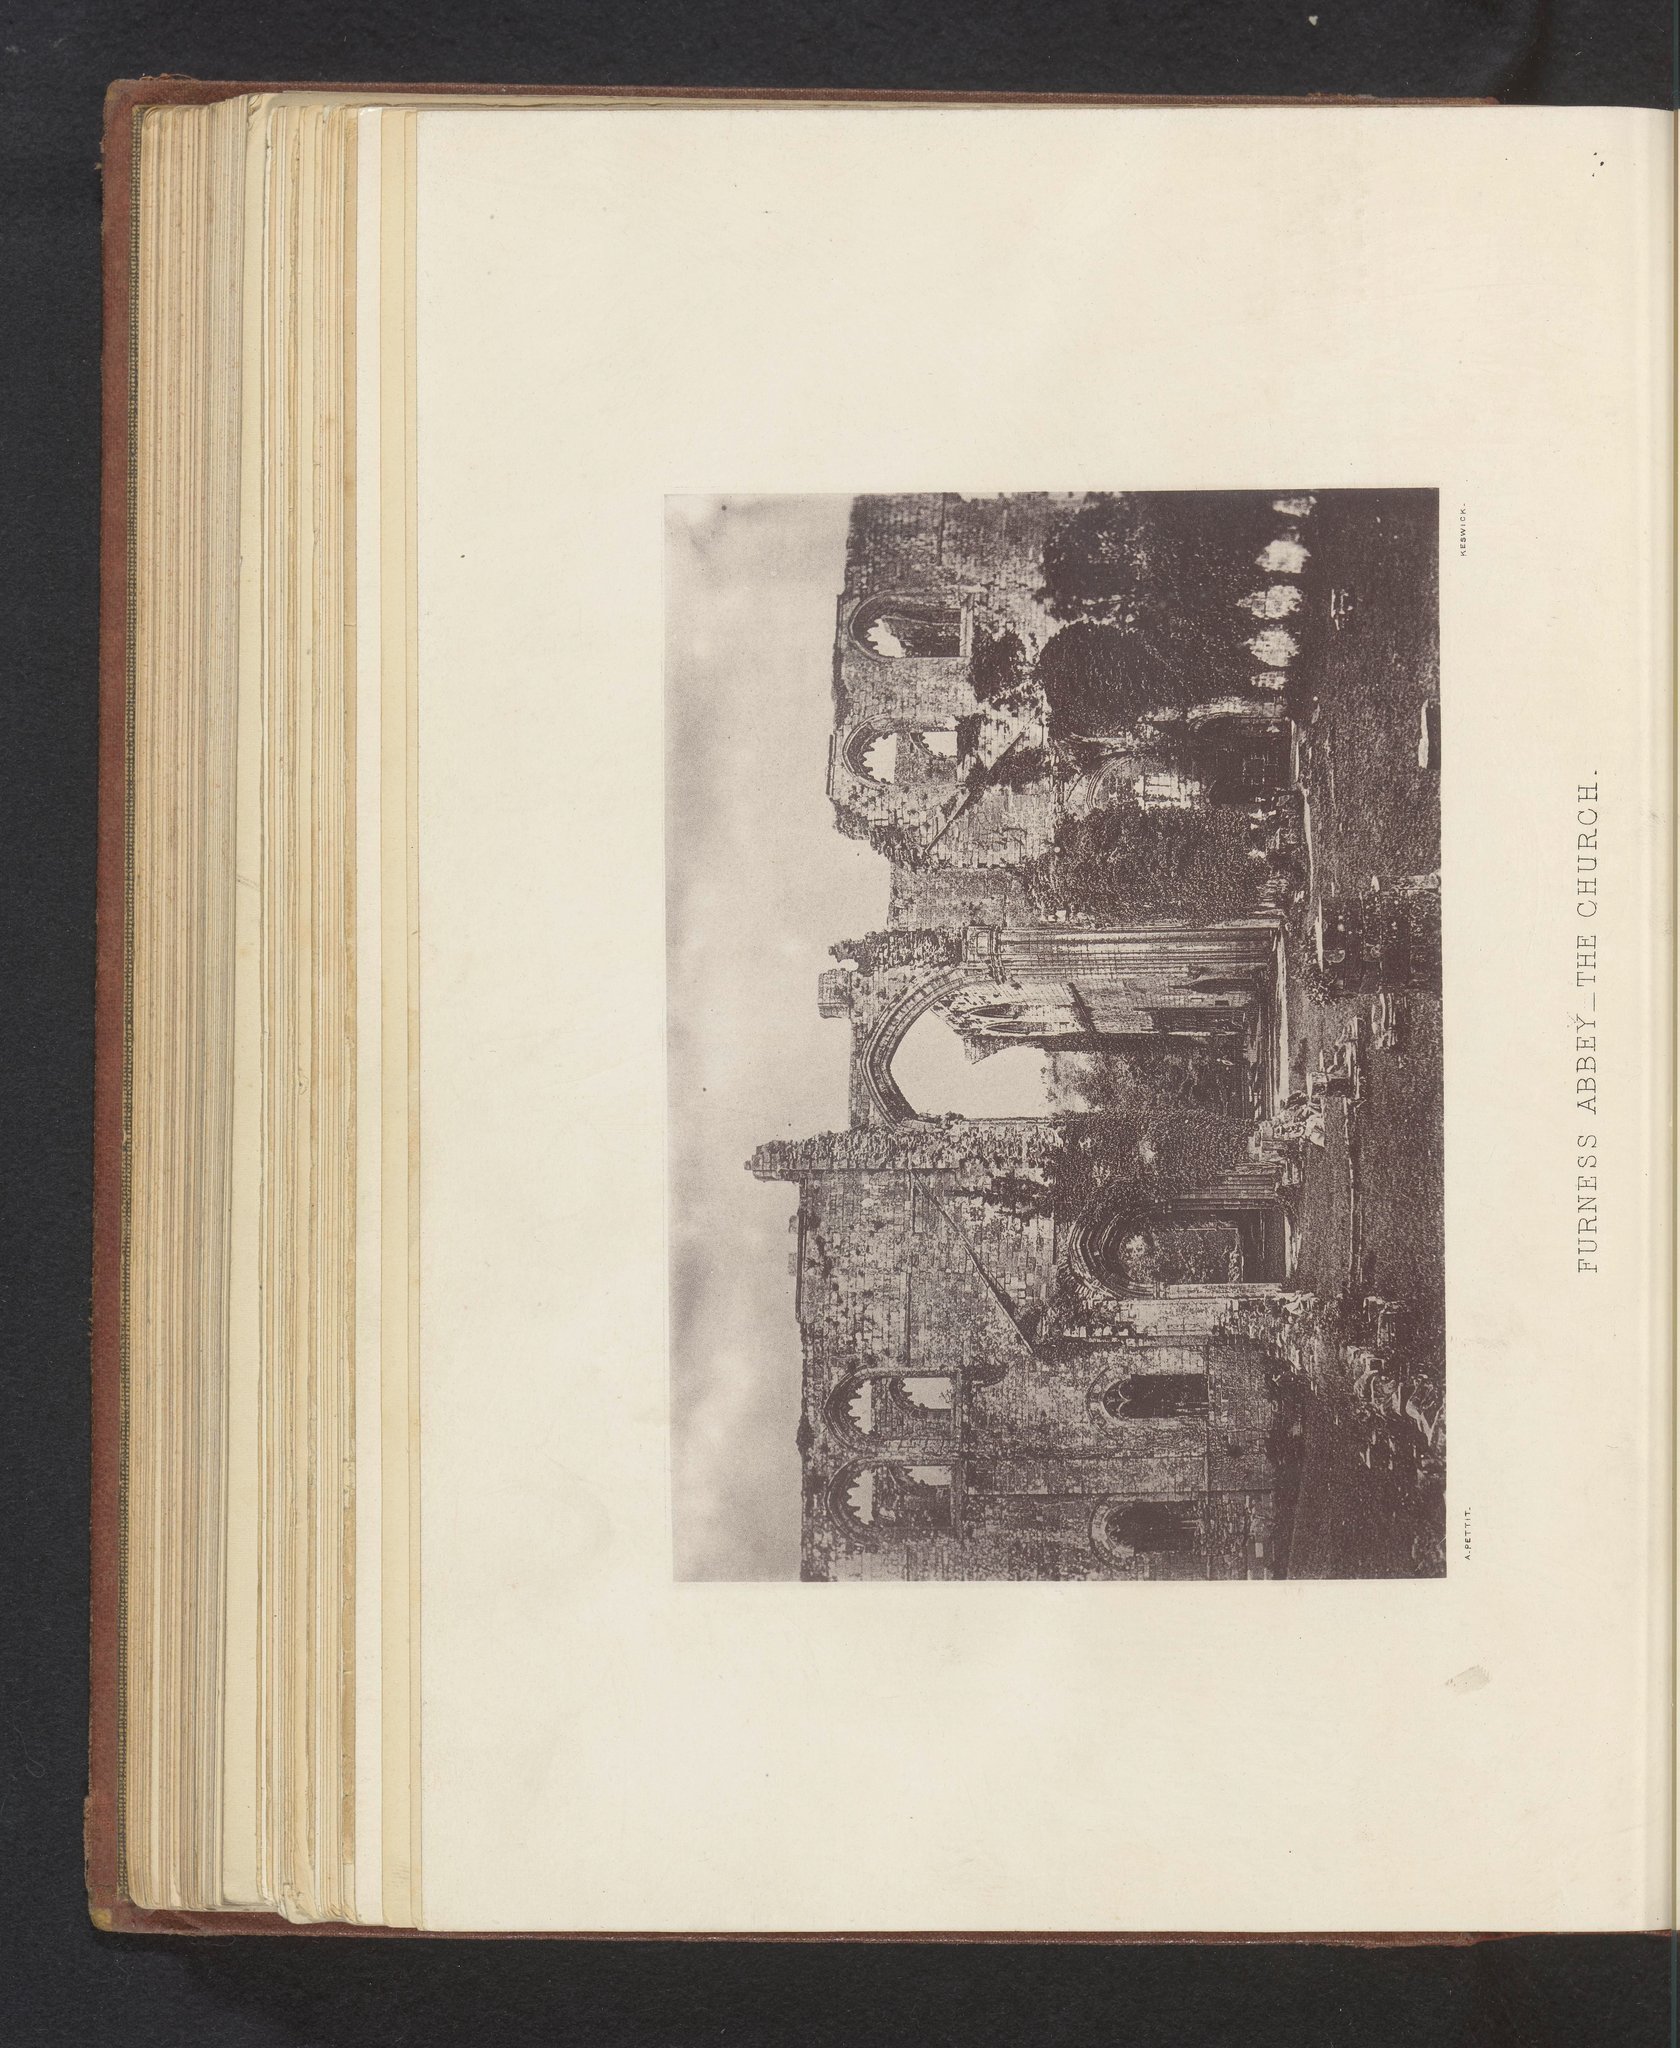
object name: photomechanical print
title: Gezicht op de ruïne van Furness Abbey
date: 1870-1880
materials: paper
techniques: heliotype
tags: abbey, monastery, convent ~ roman catholic church